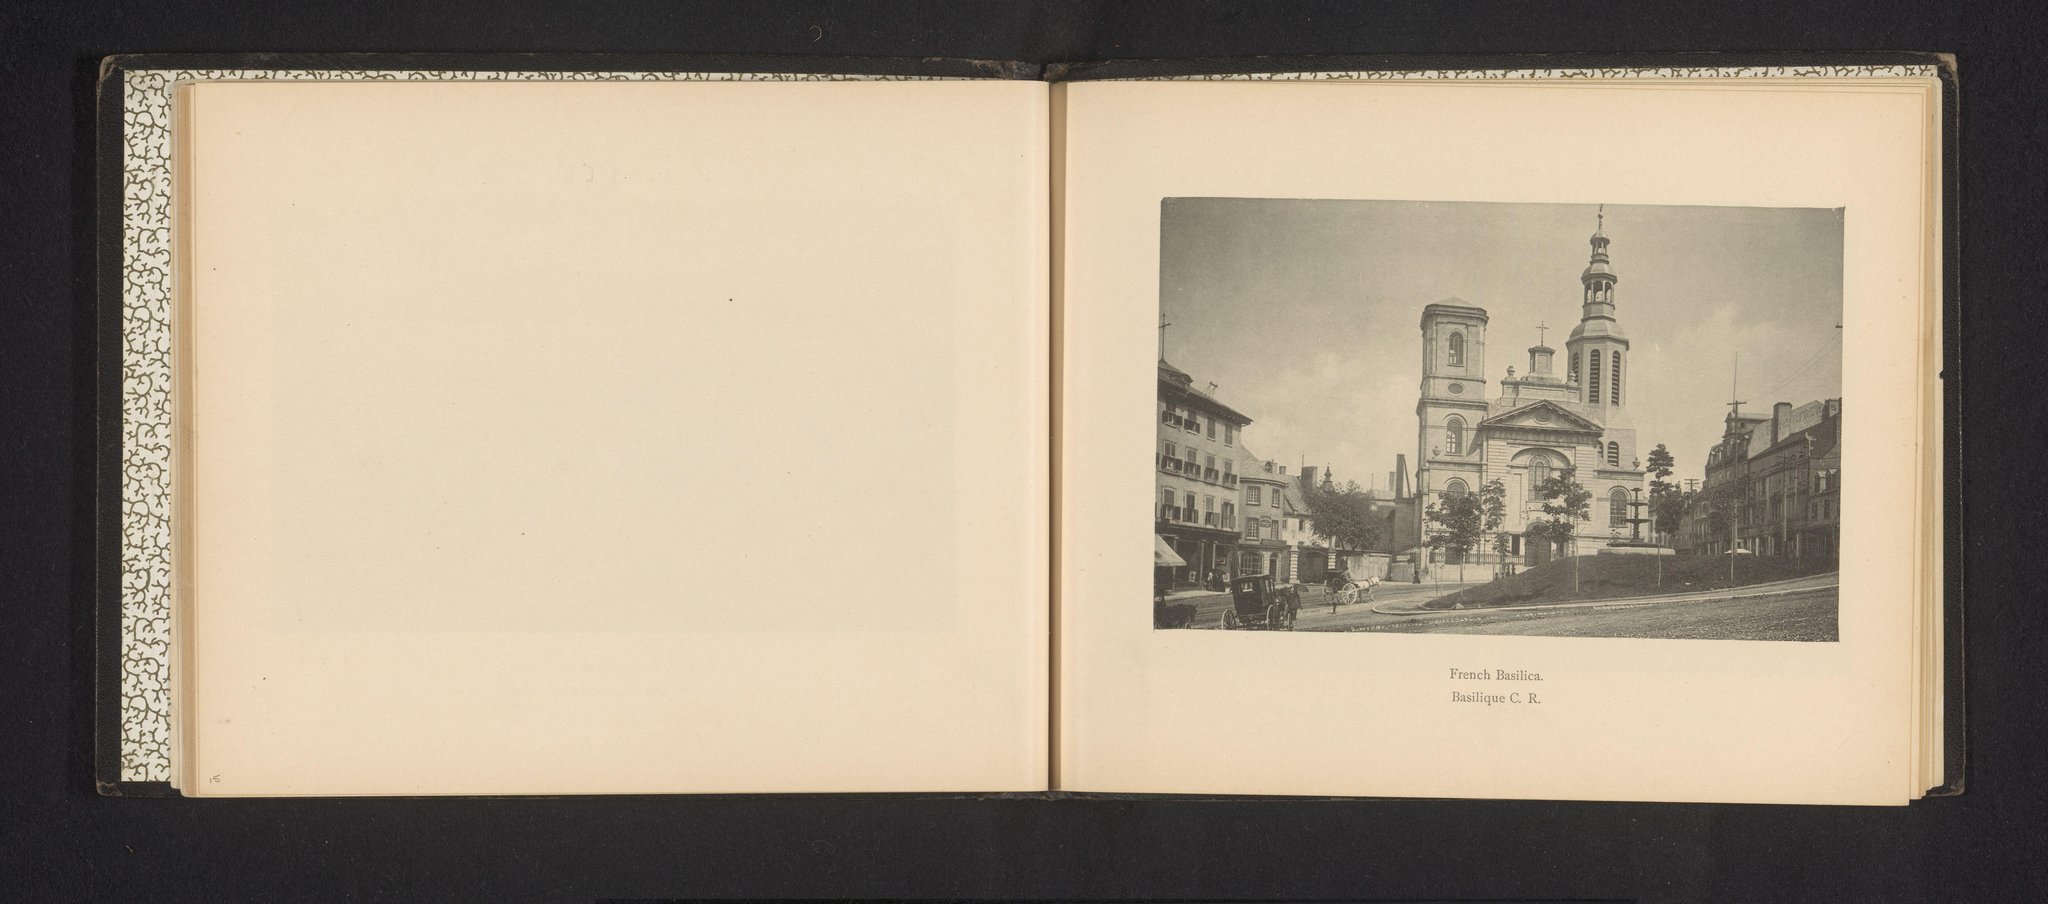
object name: page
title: Gezicht op de Notre-Dame de Québec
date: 1889-1894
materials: paper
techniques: photograph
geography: quebec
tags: church (exterior), québec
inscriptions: inscription: ‘Basilique C. R.’